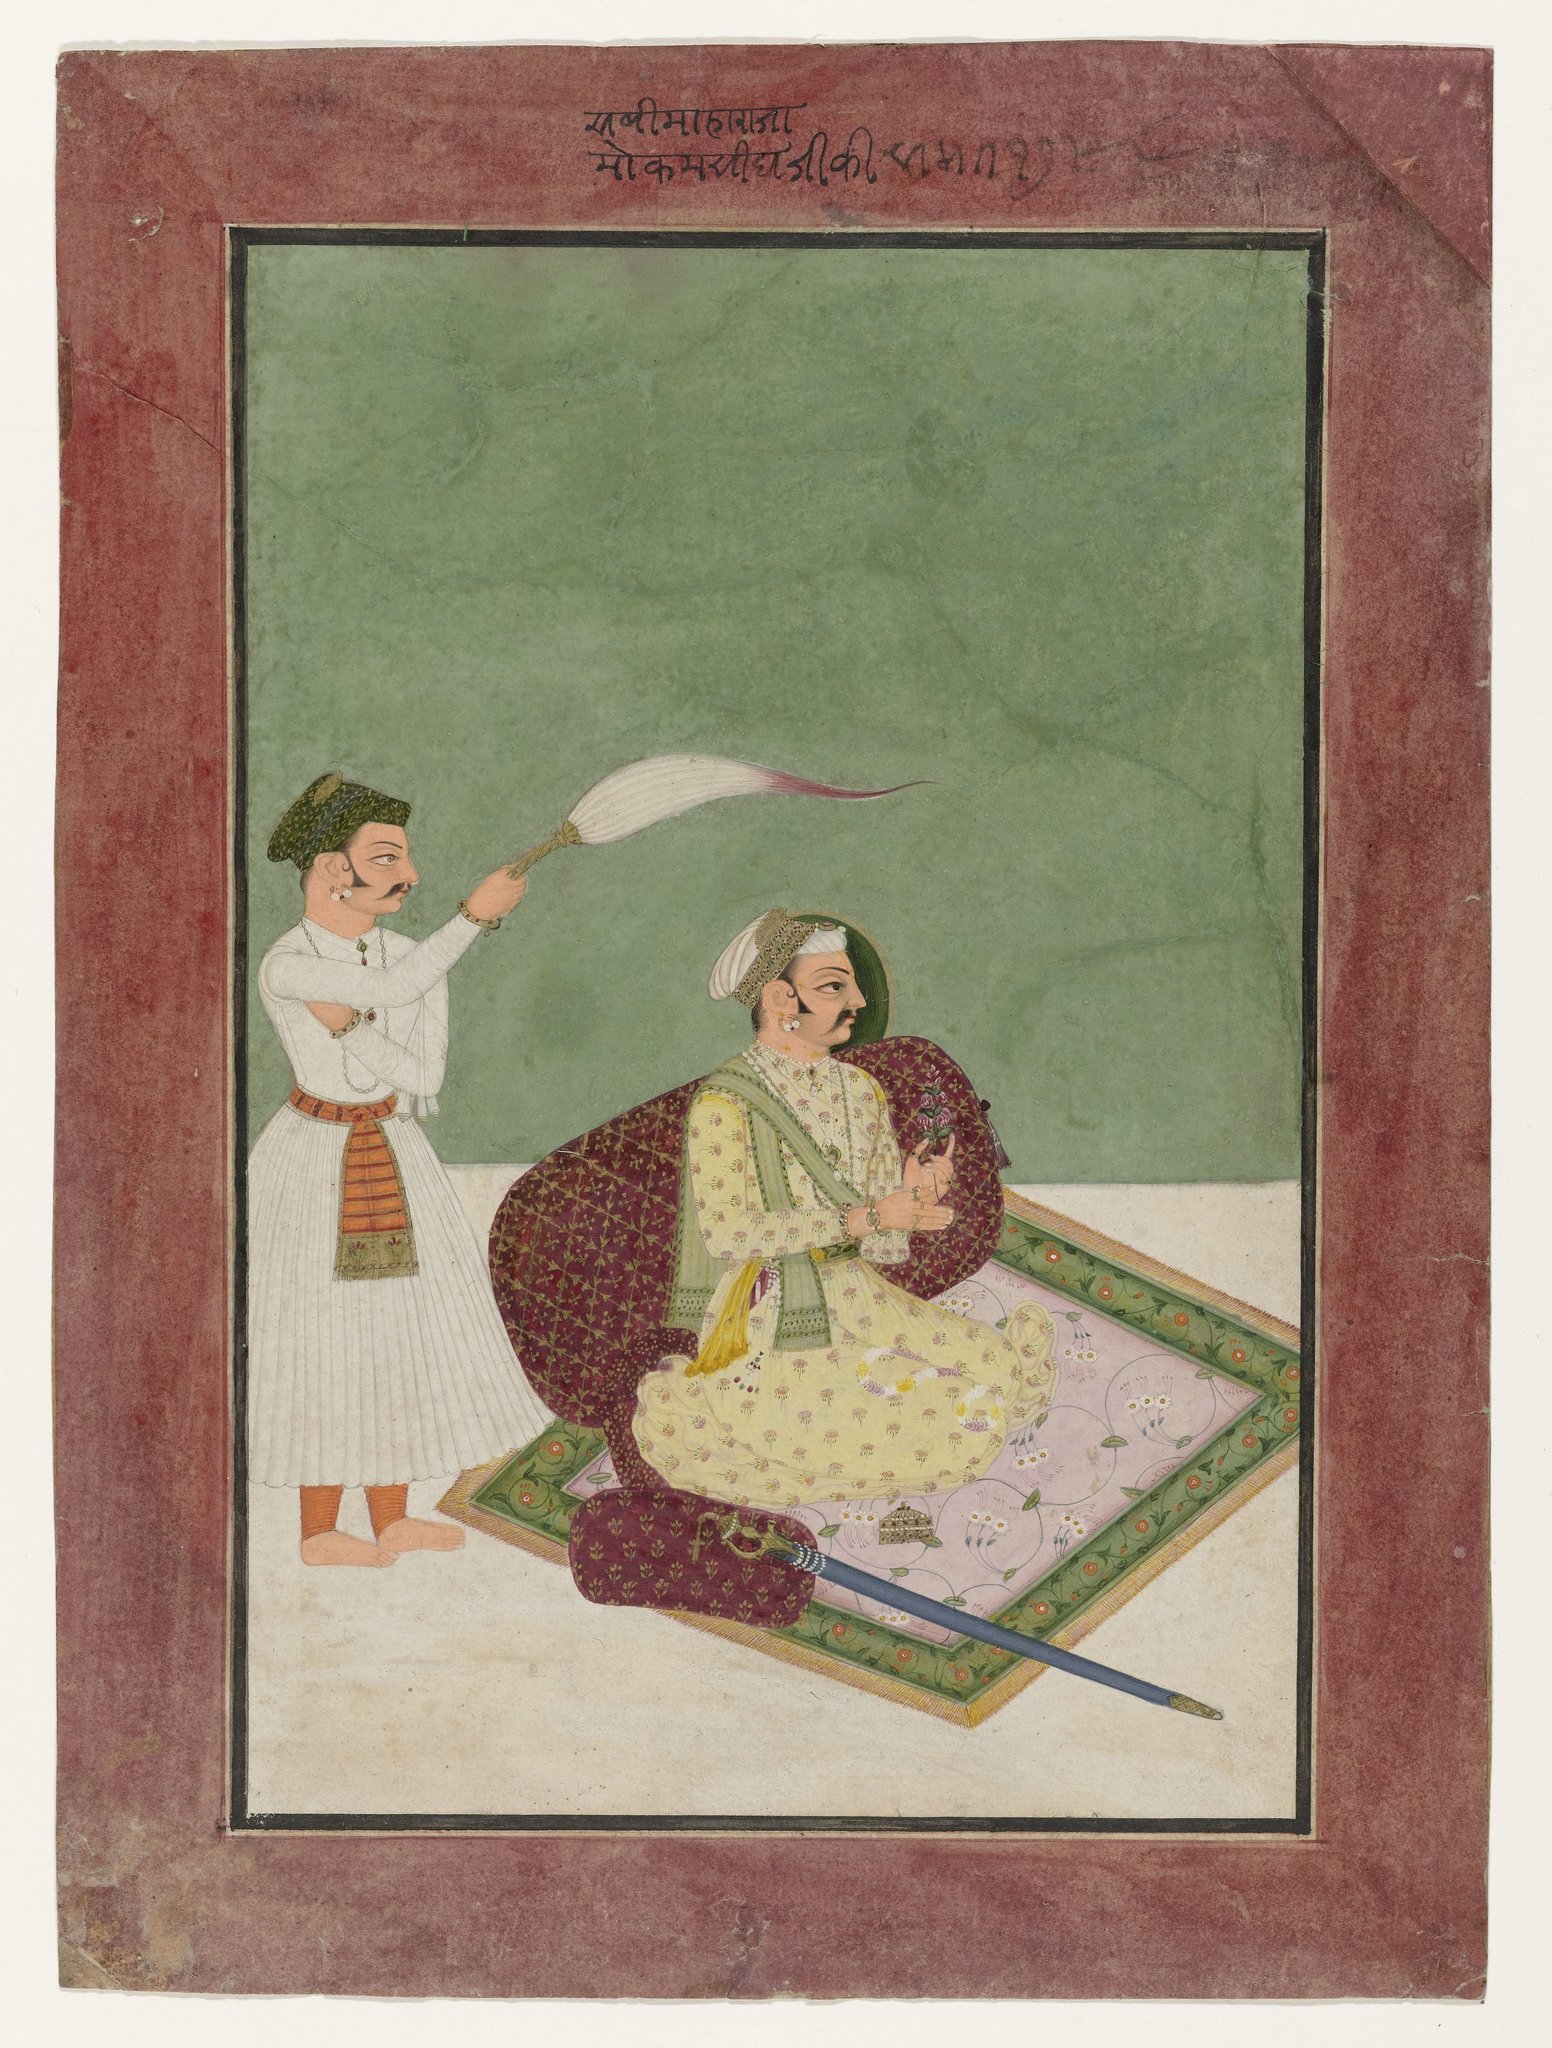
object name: indian miniature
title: Portret van Maharadja Mokam Singh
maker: Anonymous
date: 1731-1732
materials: paint, gouache, paper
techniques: brush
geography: kotah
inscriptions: date and inscription: ‘Sabi maharaja Mokam Singh ji samat 1788’